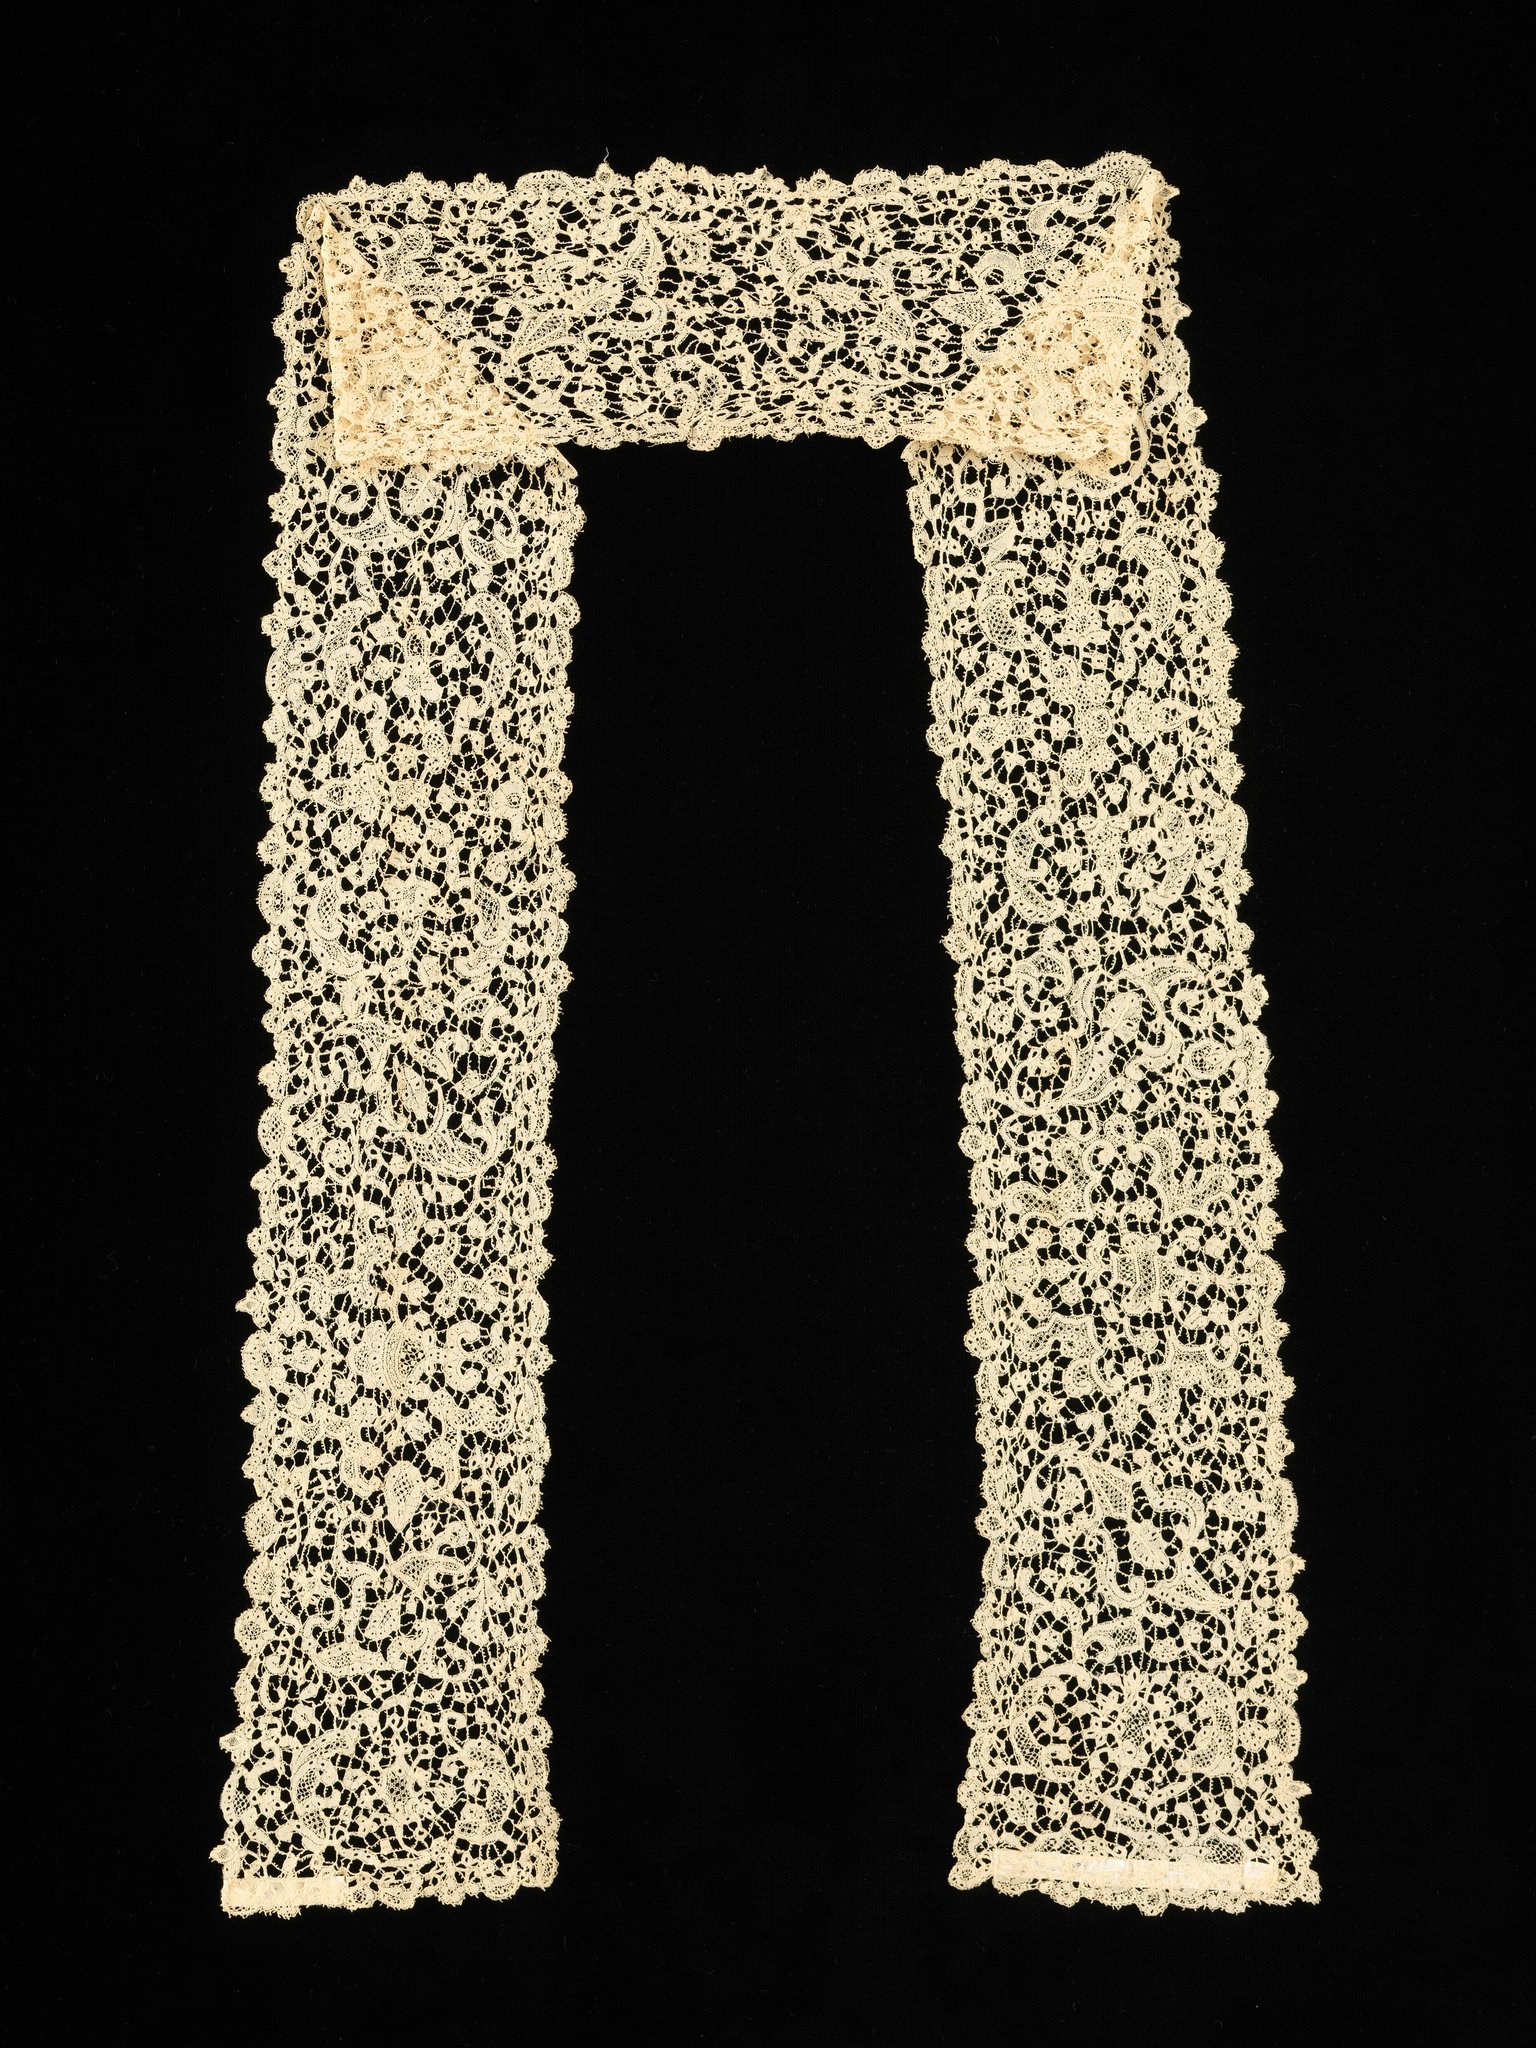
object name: lappet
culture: flemish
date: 1690-1699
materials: linen